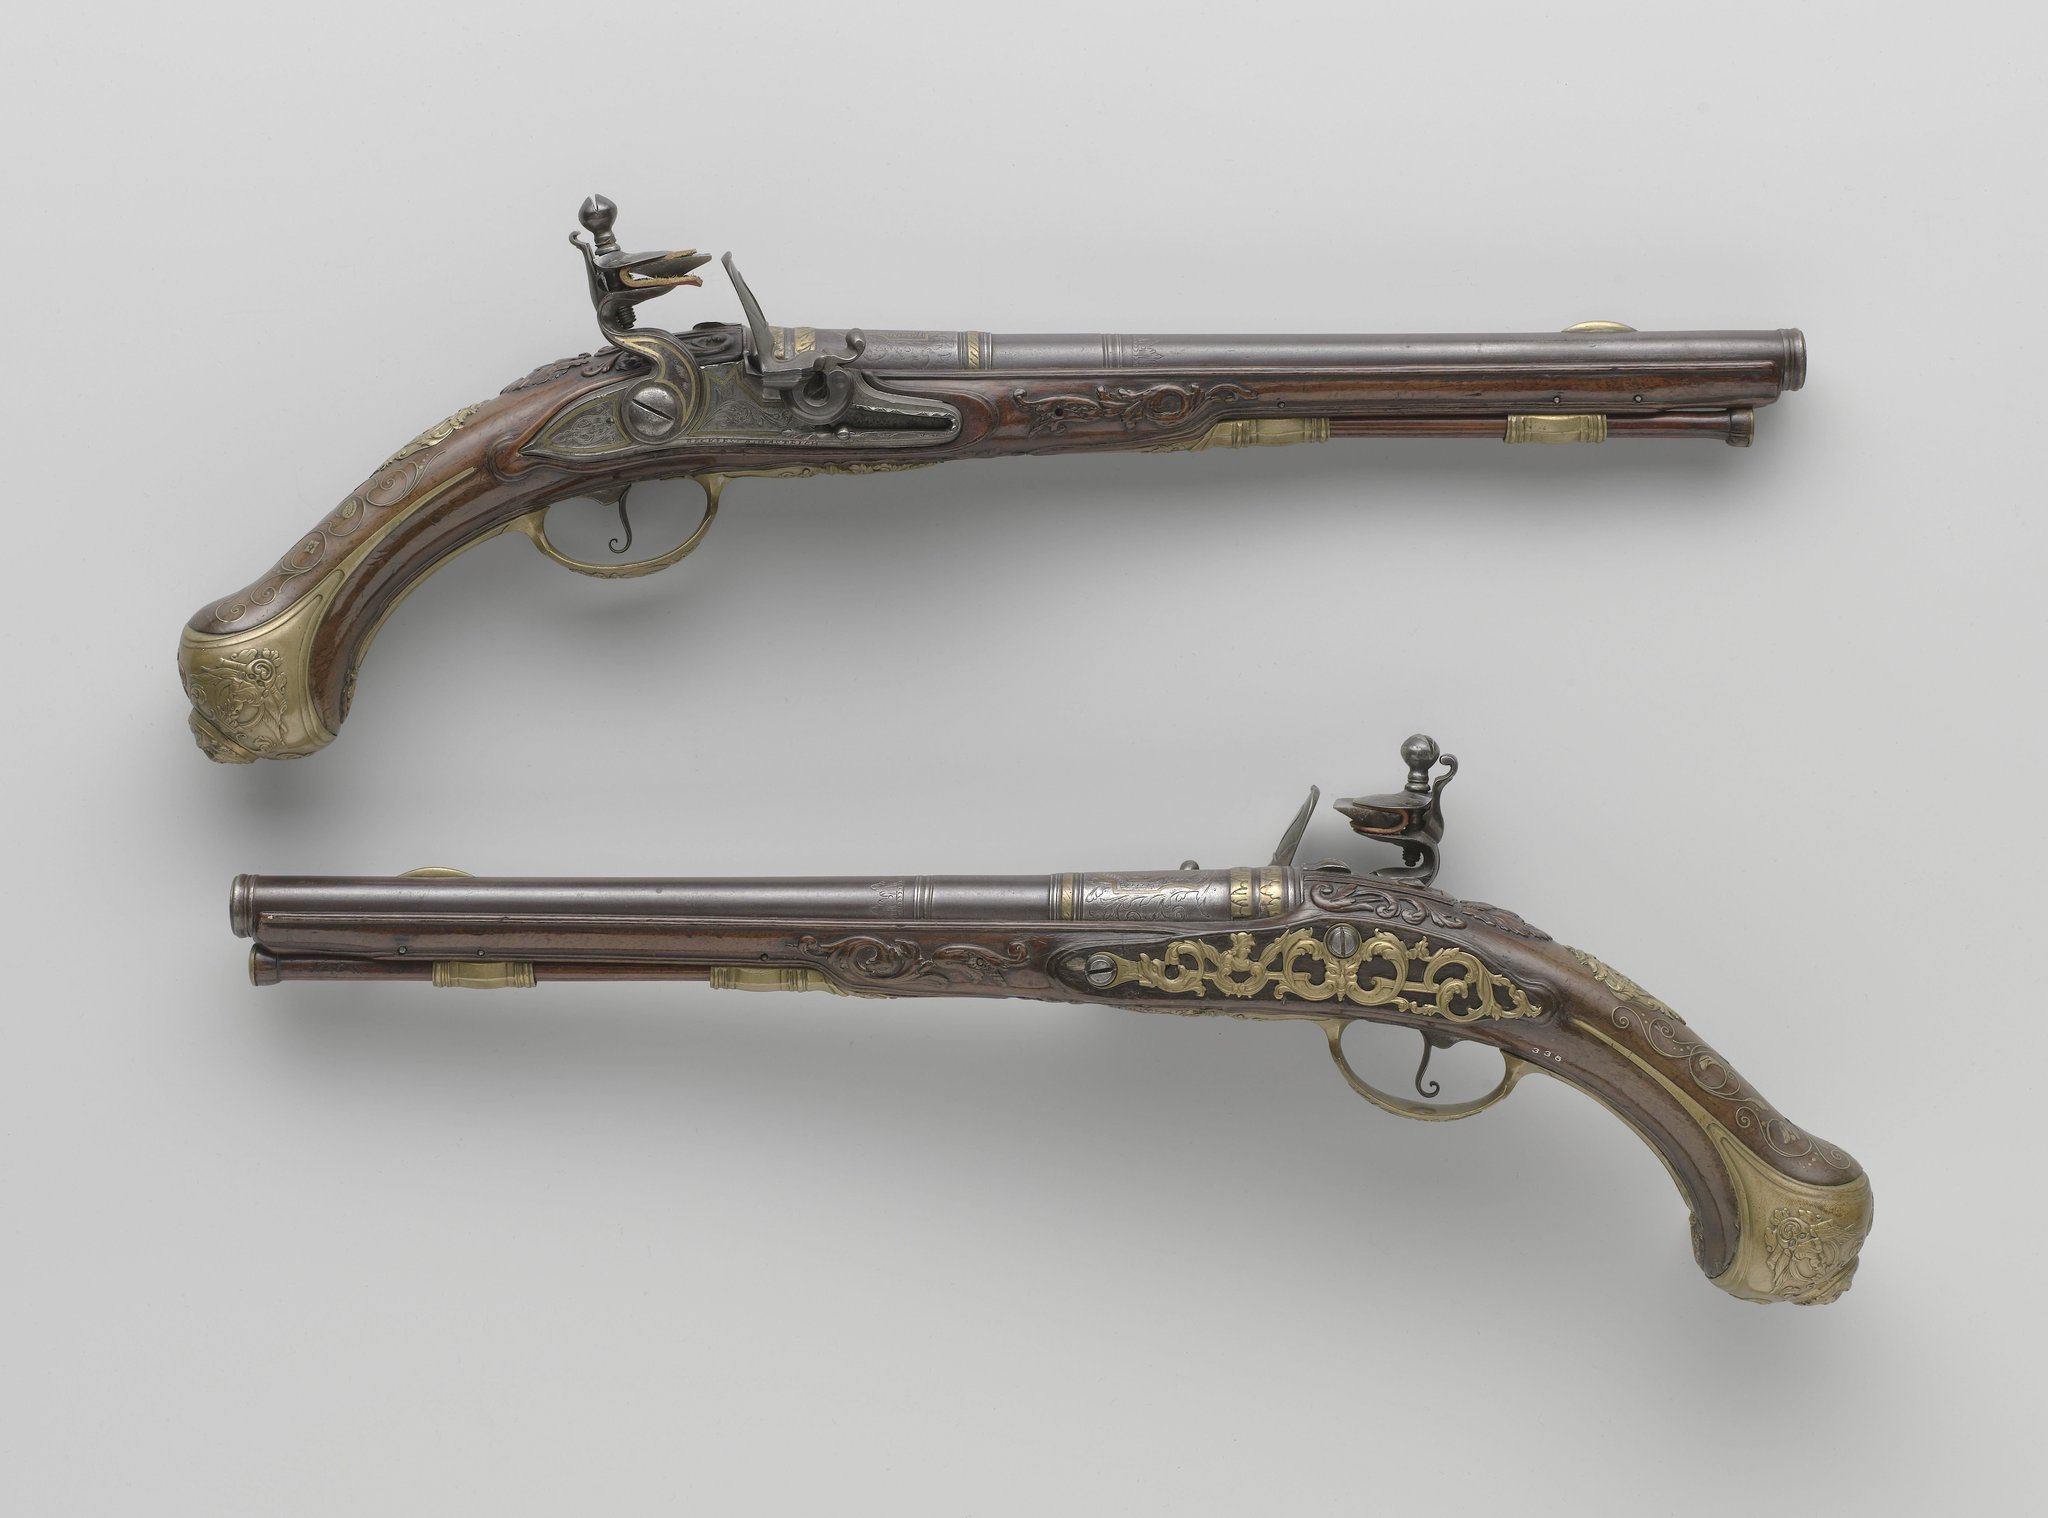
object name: flintlock pistol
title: Vuursteenpistool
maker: mattis beckers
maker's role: geweermaker, pistoolmaker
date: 1720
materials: brass, iron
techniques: printing, casting, metalworking, cutting, embroidery, engraving, gilding, inlay, relief, striking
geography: maastricht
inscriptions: signature: ‘BECKERS'A'MASTRICH’, mark: ‘T’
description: Tentoongesteld in: Stedelijk Museum De Lakenhal, Leiden, juli-sept 1978.